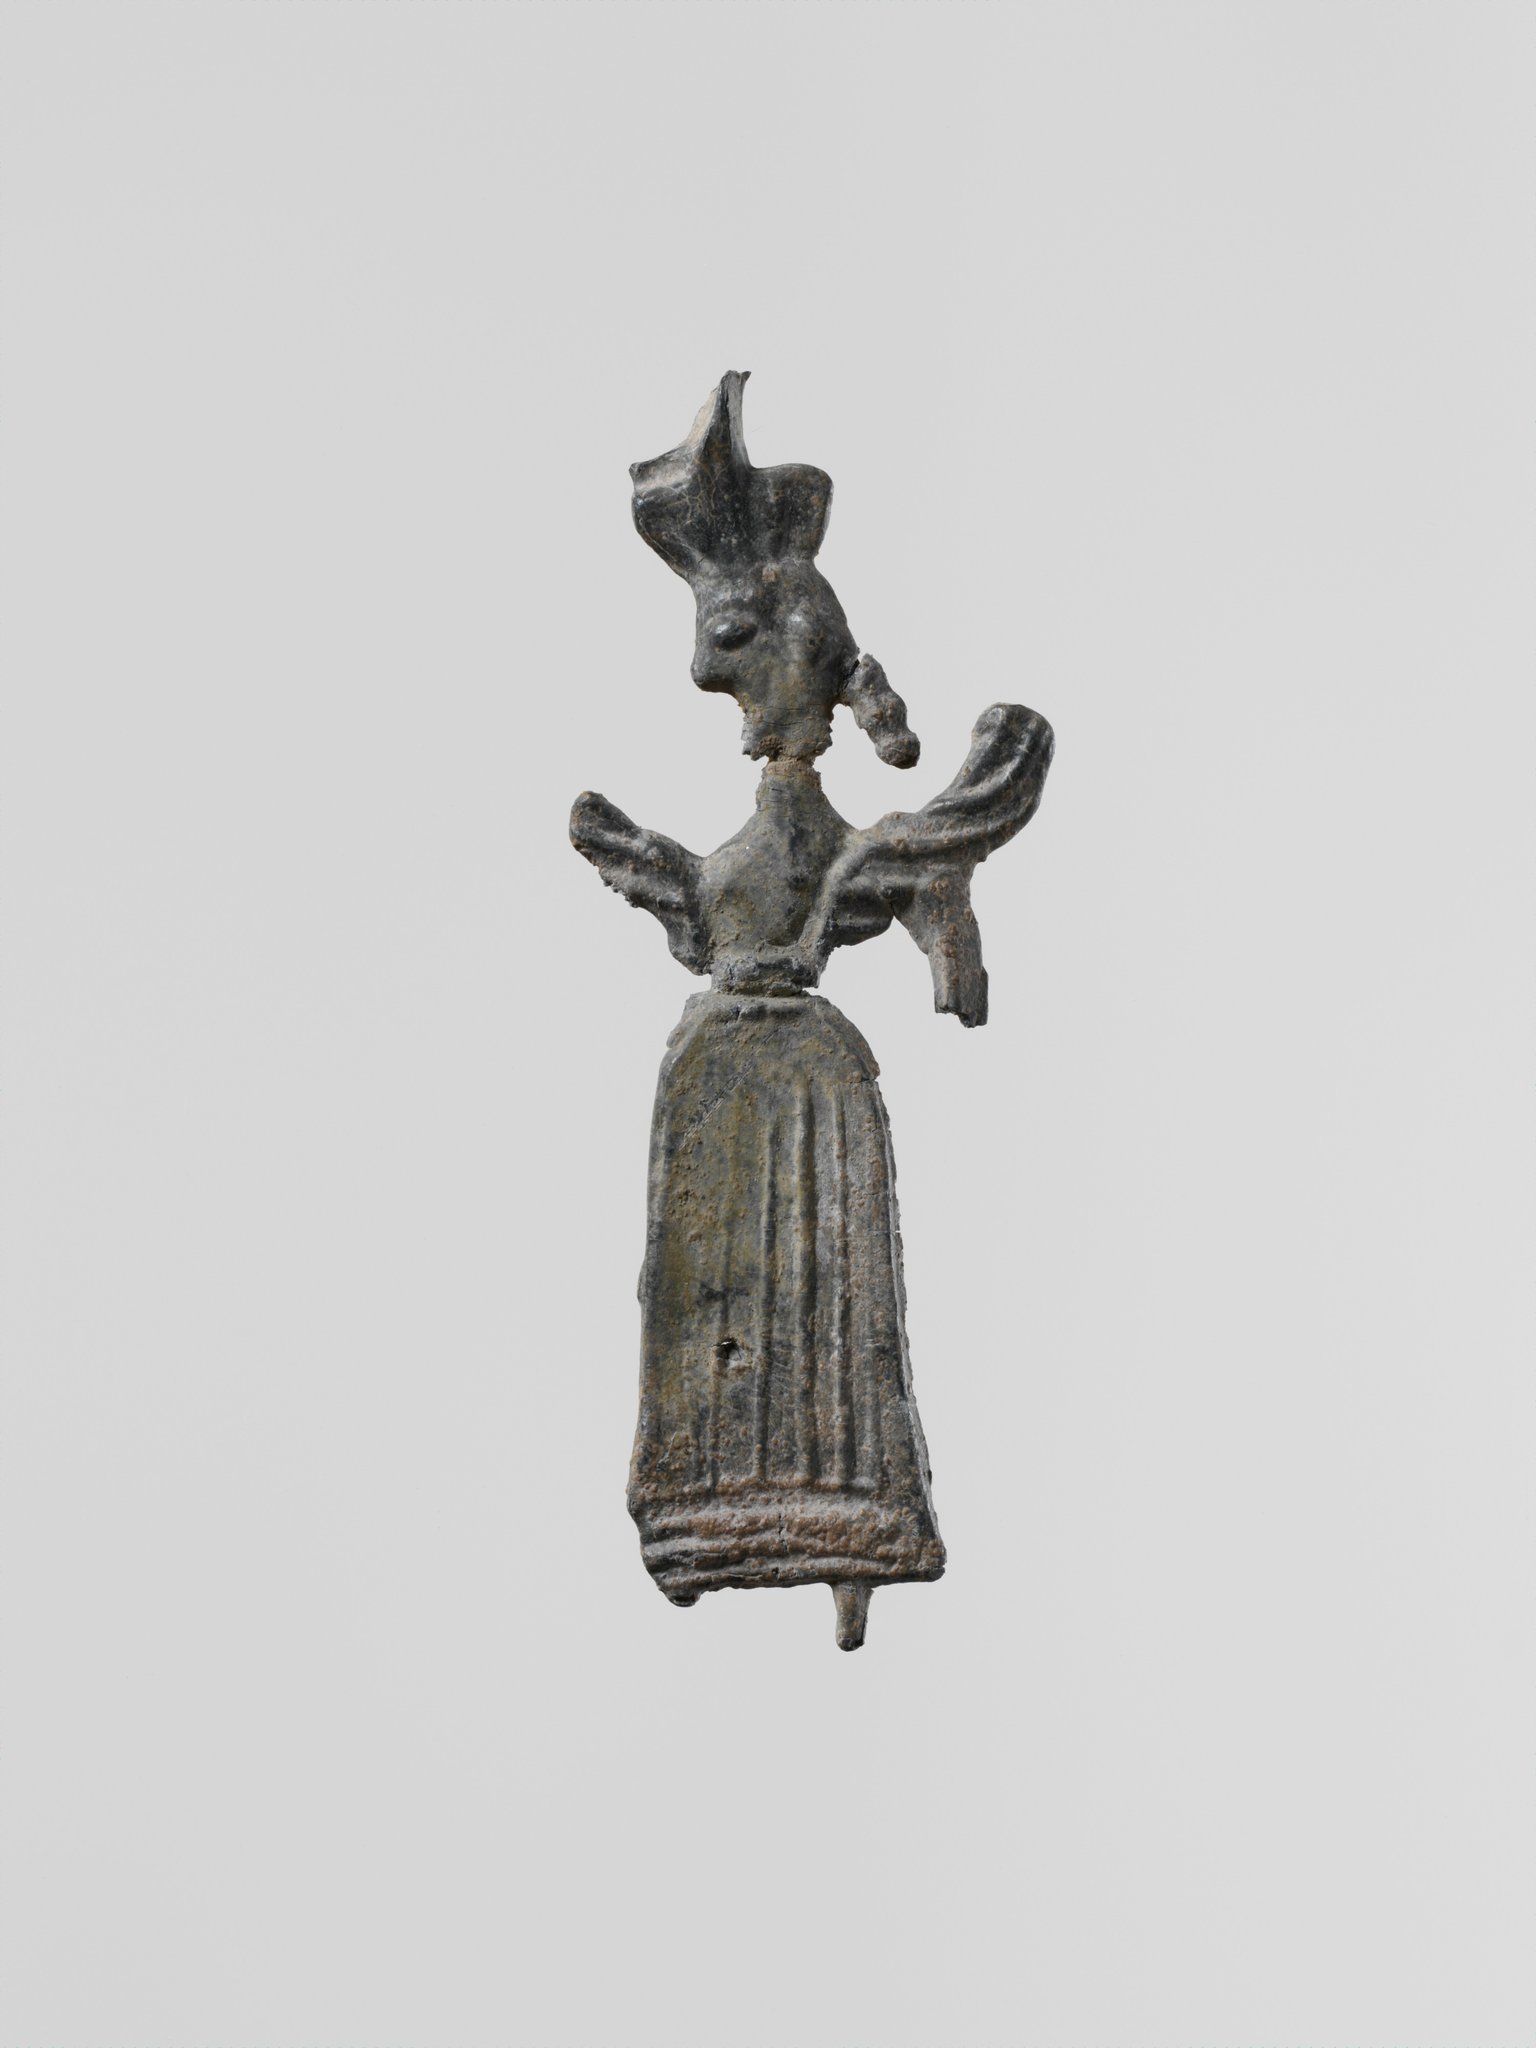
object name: statuette of artemis orthia, winged, 8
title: Lead figure of a winged goddess, possibly Artemis Orthia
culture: greek, laconian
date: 634-501 BCE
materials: lead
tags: artemis,goddess